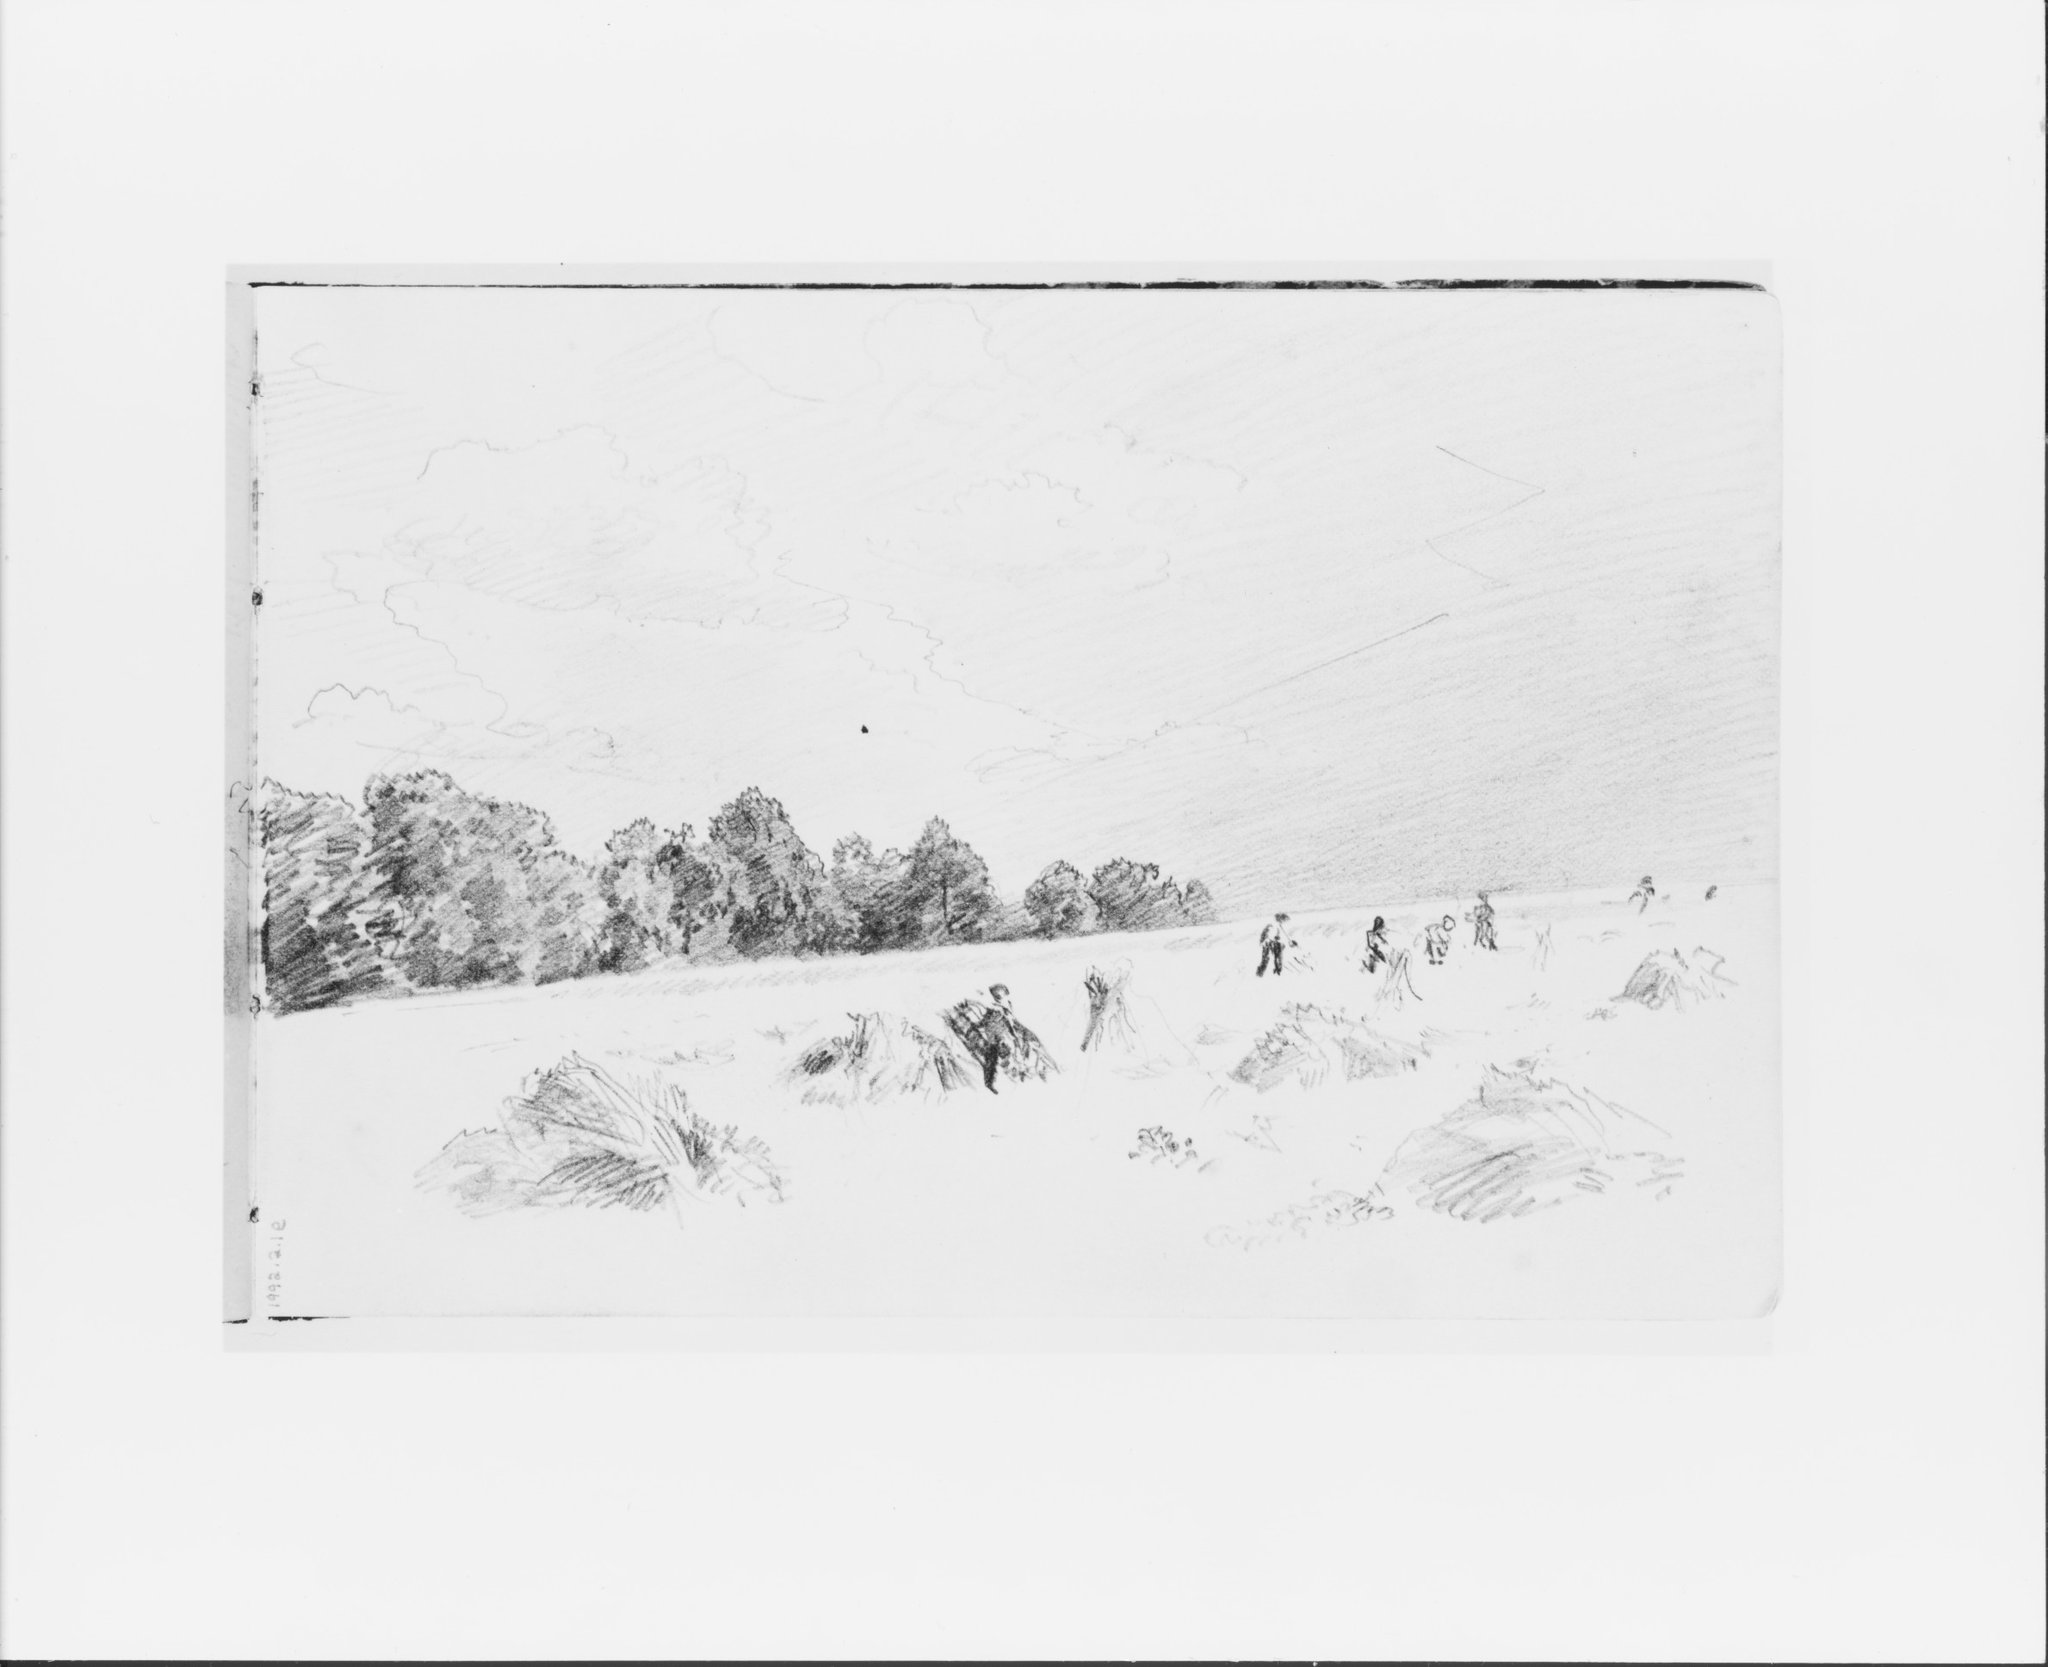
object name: drawing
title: Field with Laborers (from Sketchbook VII)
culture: american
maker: william trost richards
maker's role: artist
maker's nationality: american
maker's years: 1833-1905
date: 1886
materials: graphite, paper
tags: landscapes,trees